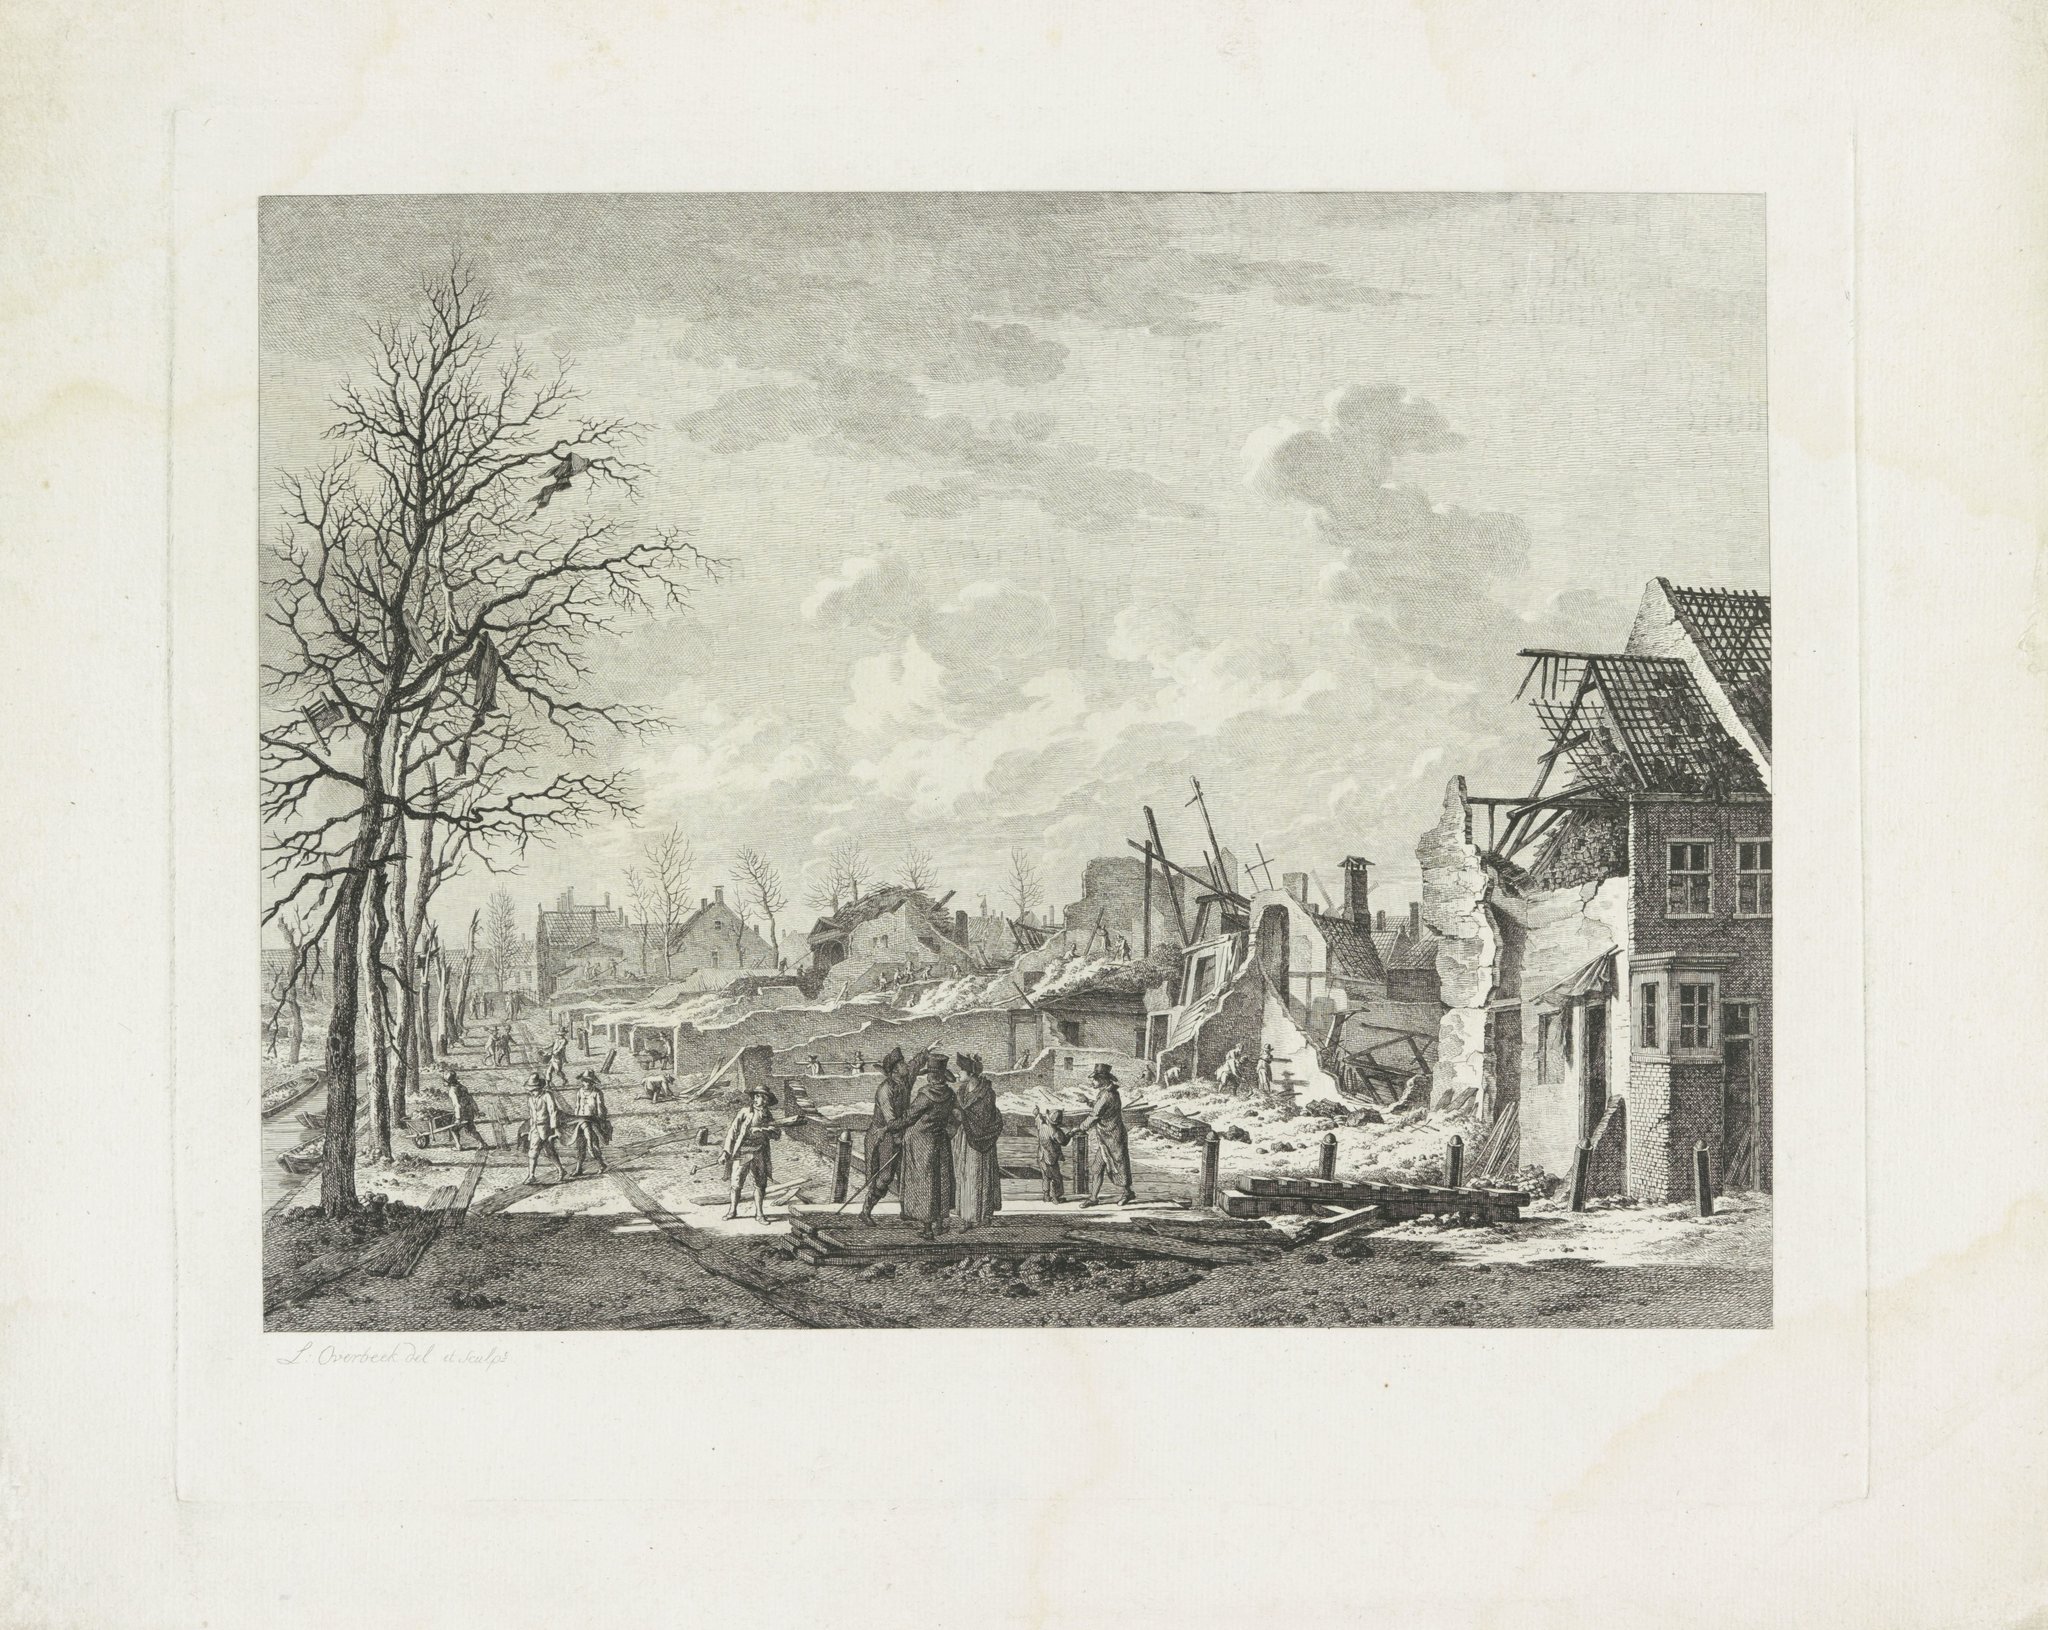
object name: print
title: Ruïnes op het Steenschuur (zuidzijde) na de Leidse buskruitramp, 1807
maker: leendert overbeek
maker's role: draughtsman, painter, print maker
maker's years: 1752-1815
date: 1807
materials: paper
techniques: engraving, etching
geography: leiden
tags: gunpowder disaster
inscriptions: collector's mark: Lugt 2228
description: Opruimwerkzaamheden bij de verwoeste gebouwen aan de zuidzijde van het Steenschuur te Leiden na de buskruitramp op 12 januari 1807. Zie ook de pendant.